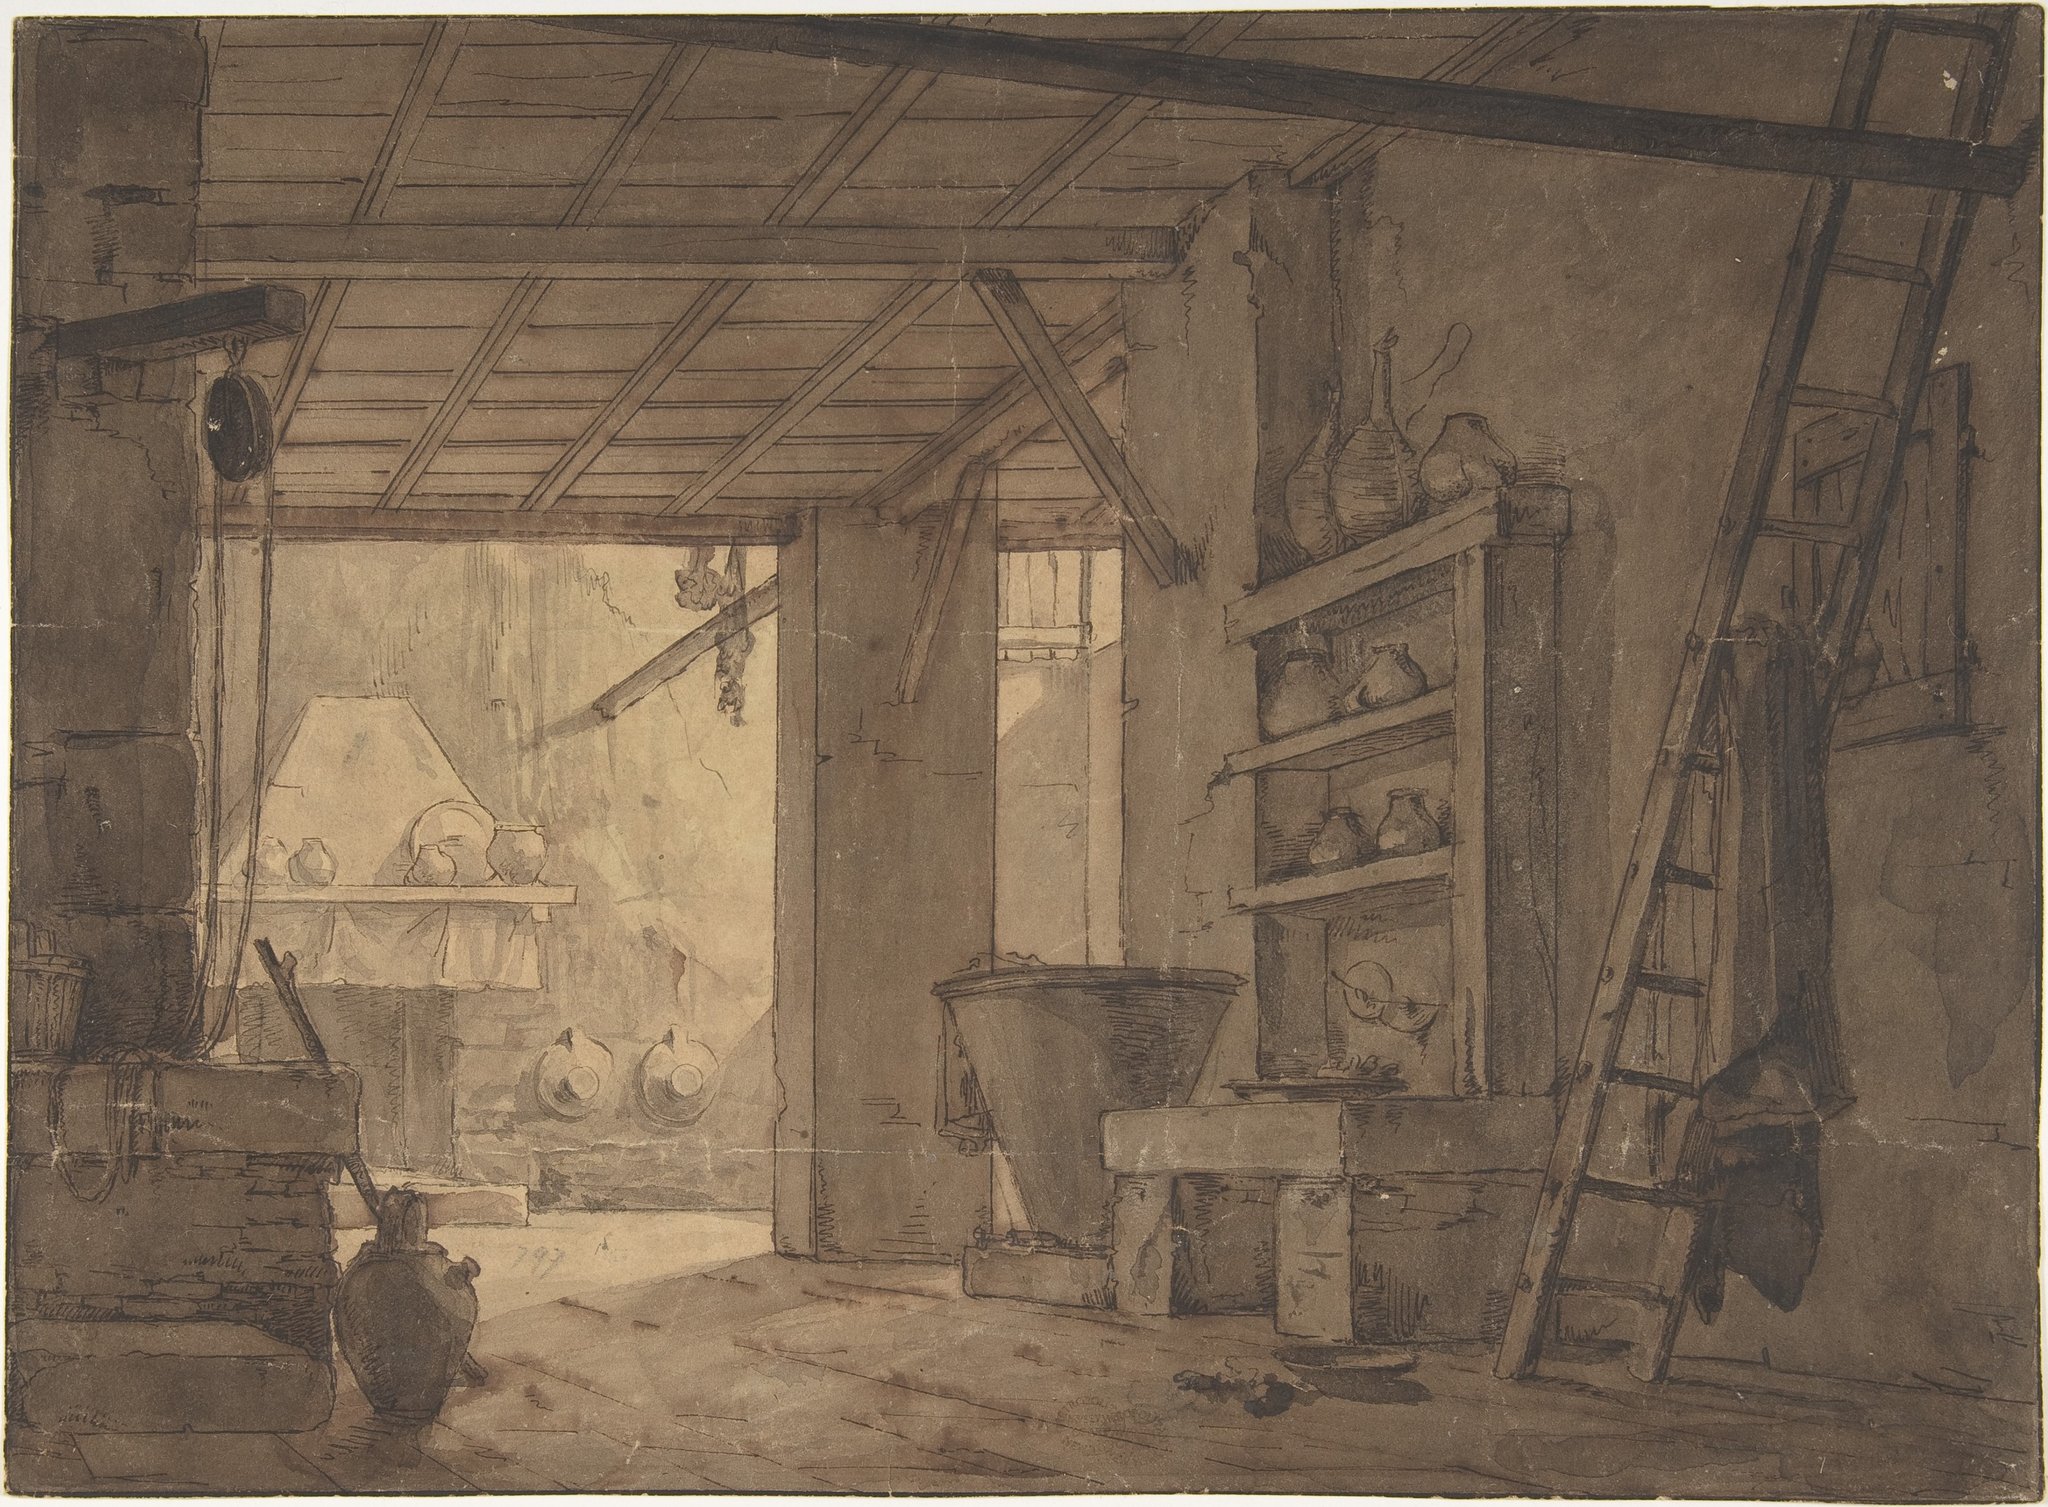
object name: drawing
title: Interior of Farm House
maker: anonymous, german, 18th century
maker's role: artist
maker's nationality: german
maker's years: 1700-1800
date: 1701-1800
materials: ink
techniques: brush, pen, wash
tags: houses,interiors,ladders